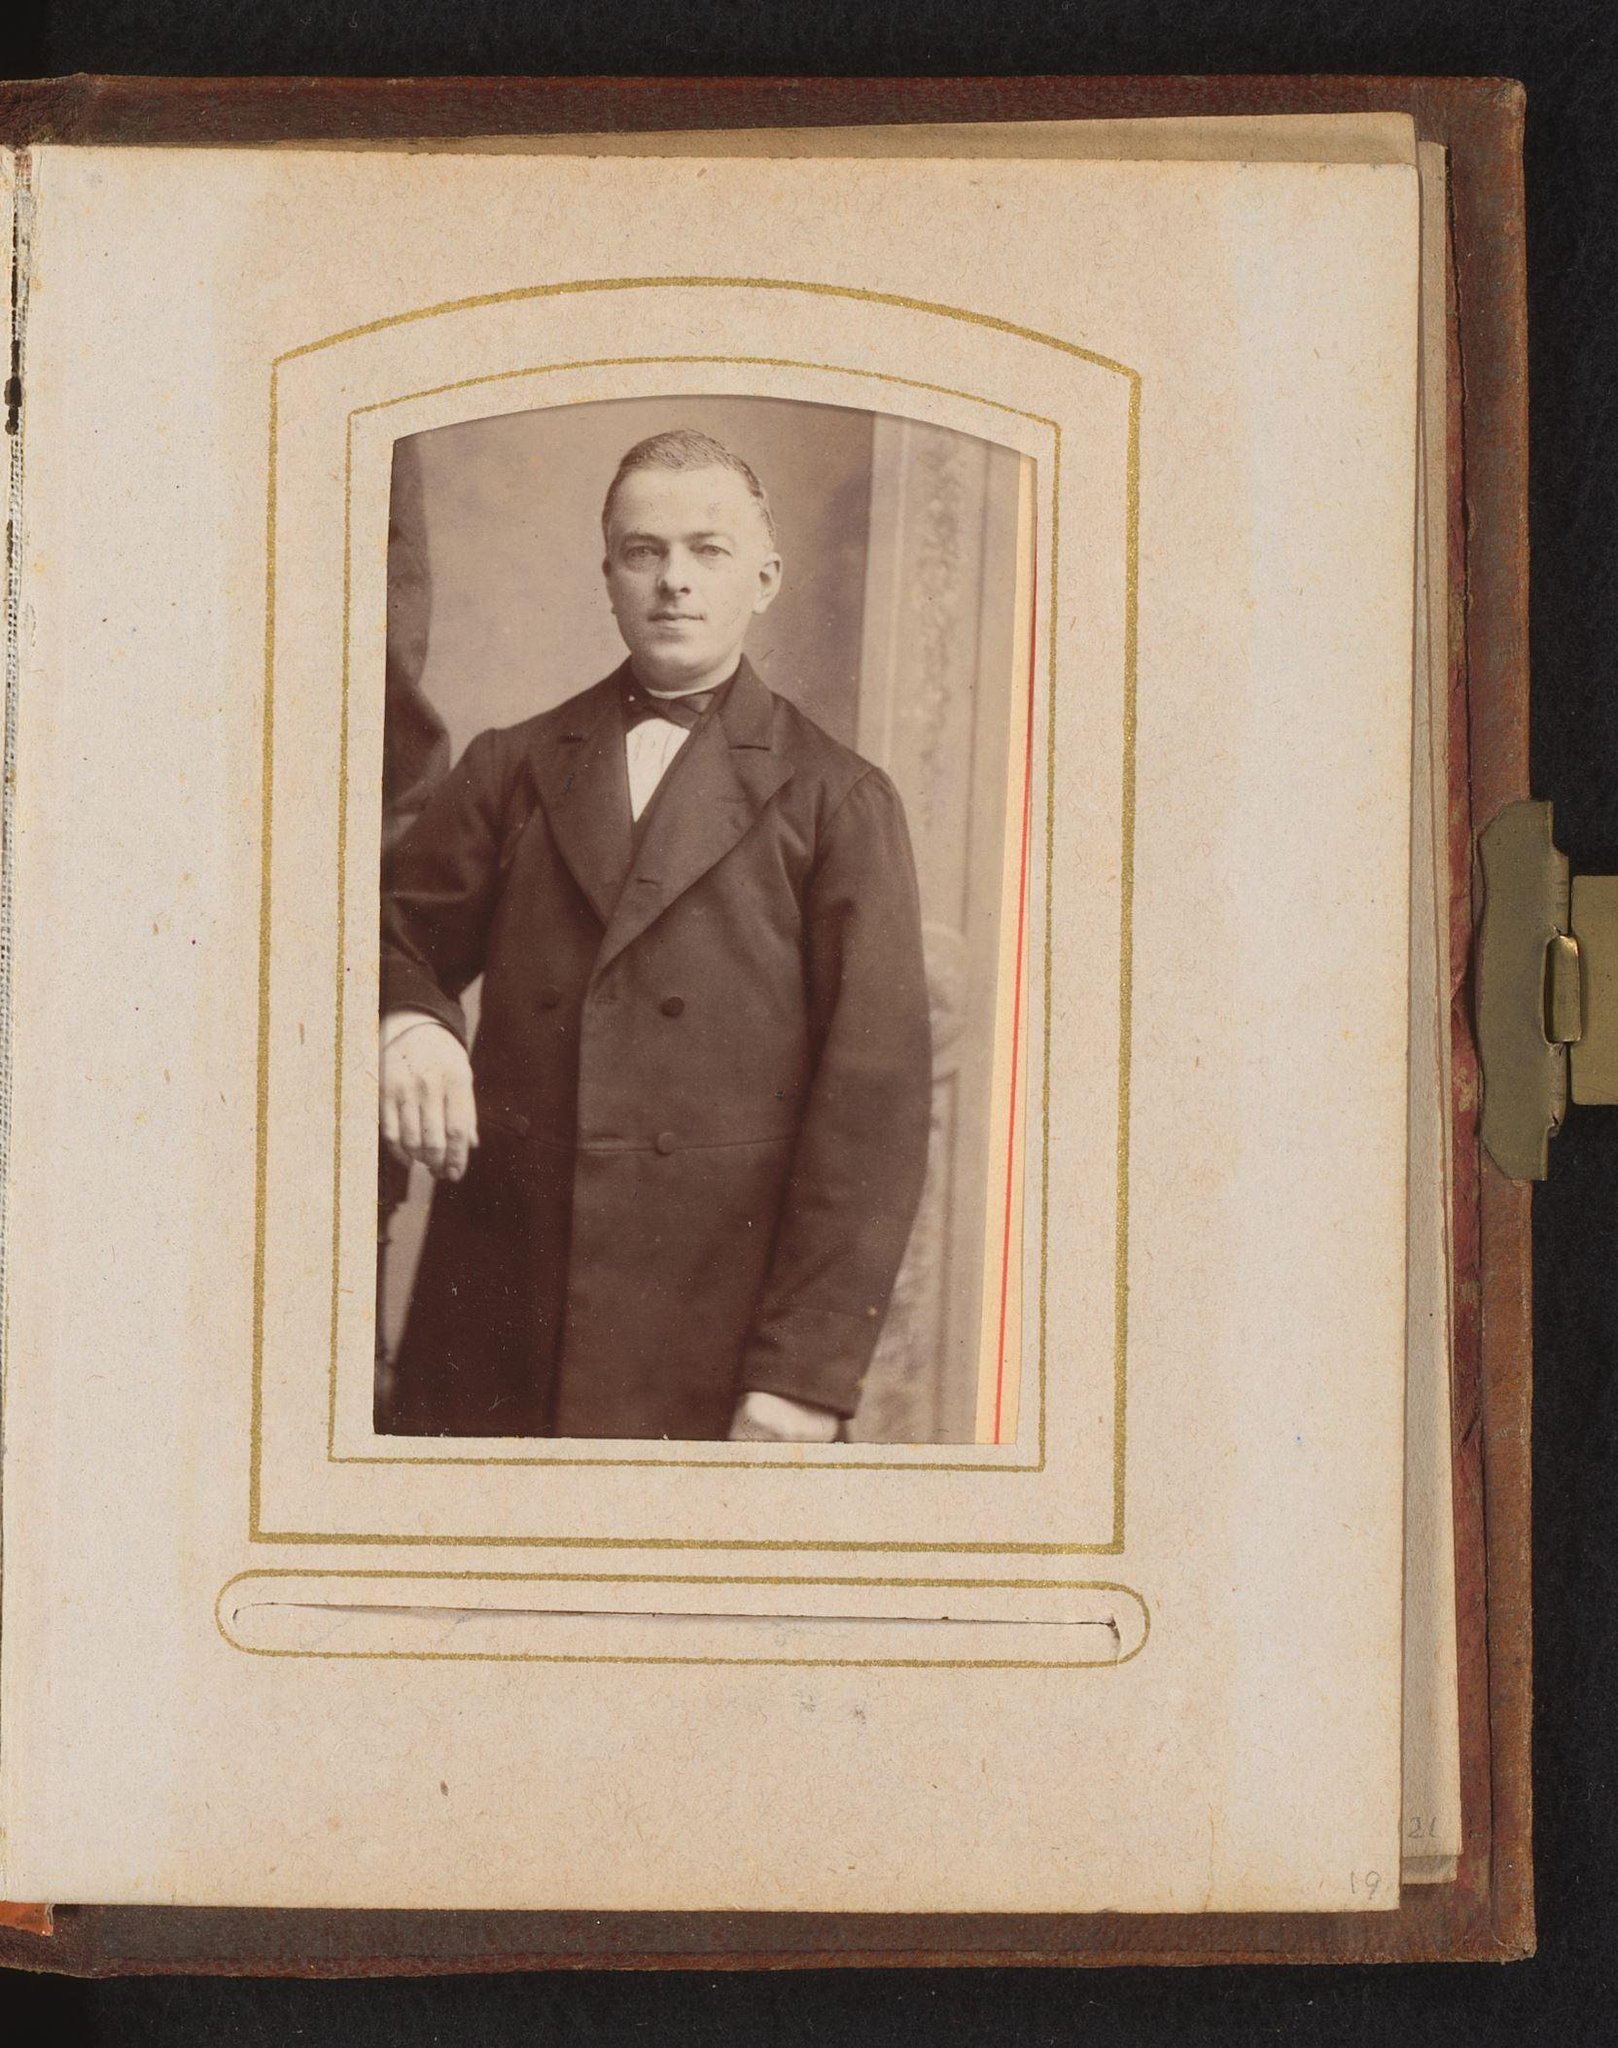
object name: photograph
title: Portret van een man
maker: johannes ephraim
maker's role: fotograaf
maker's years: 1838-1921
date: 1867-1904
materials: cardboard, photographic support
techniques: albumen print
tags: adult man, historical persons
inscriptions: inscription: ‘J. Ephraim, Arnhem’